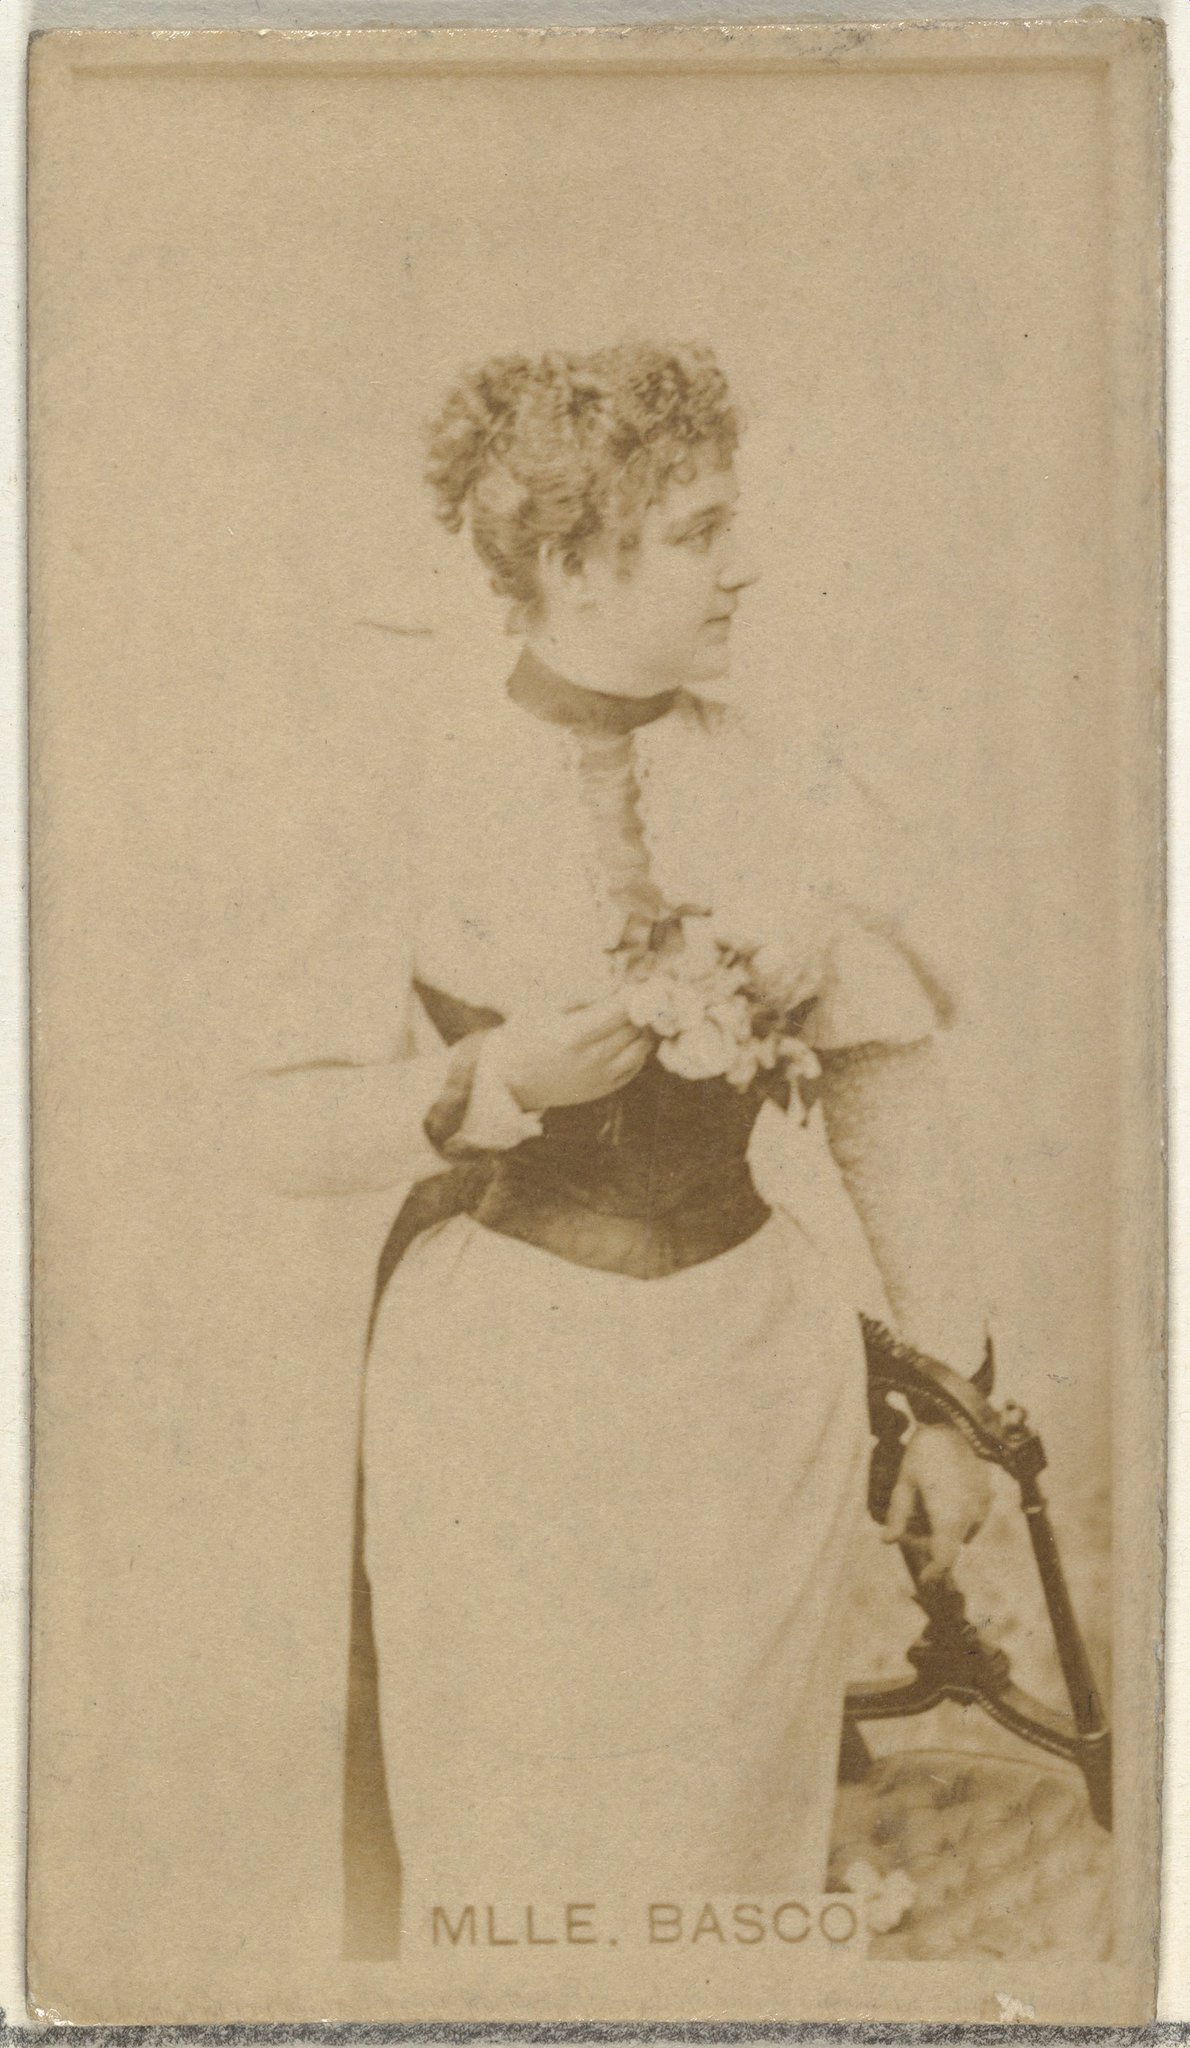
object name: photograph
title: Mlle. Basco, from the Actors and Actresses series (N145-8) issued by Duke Sons & Co. to promote Duke Cigarettes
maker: w. duke, sons & co.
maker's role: publisher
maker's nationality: american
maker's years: 1870-1920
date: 1891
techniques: albumen silver print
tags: portraits,women,actresses